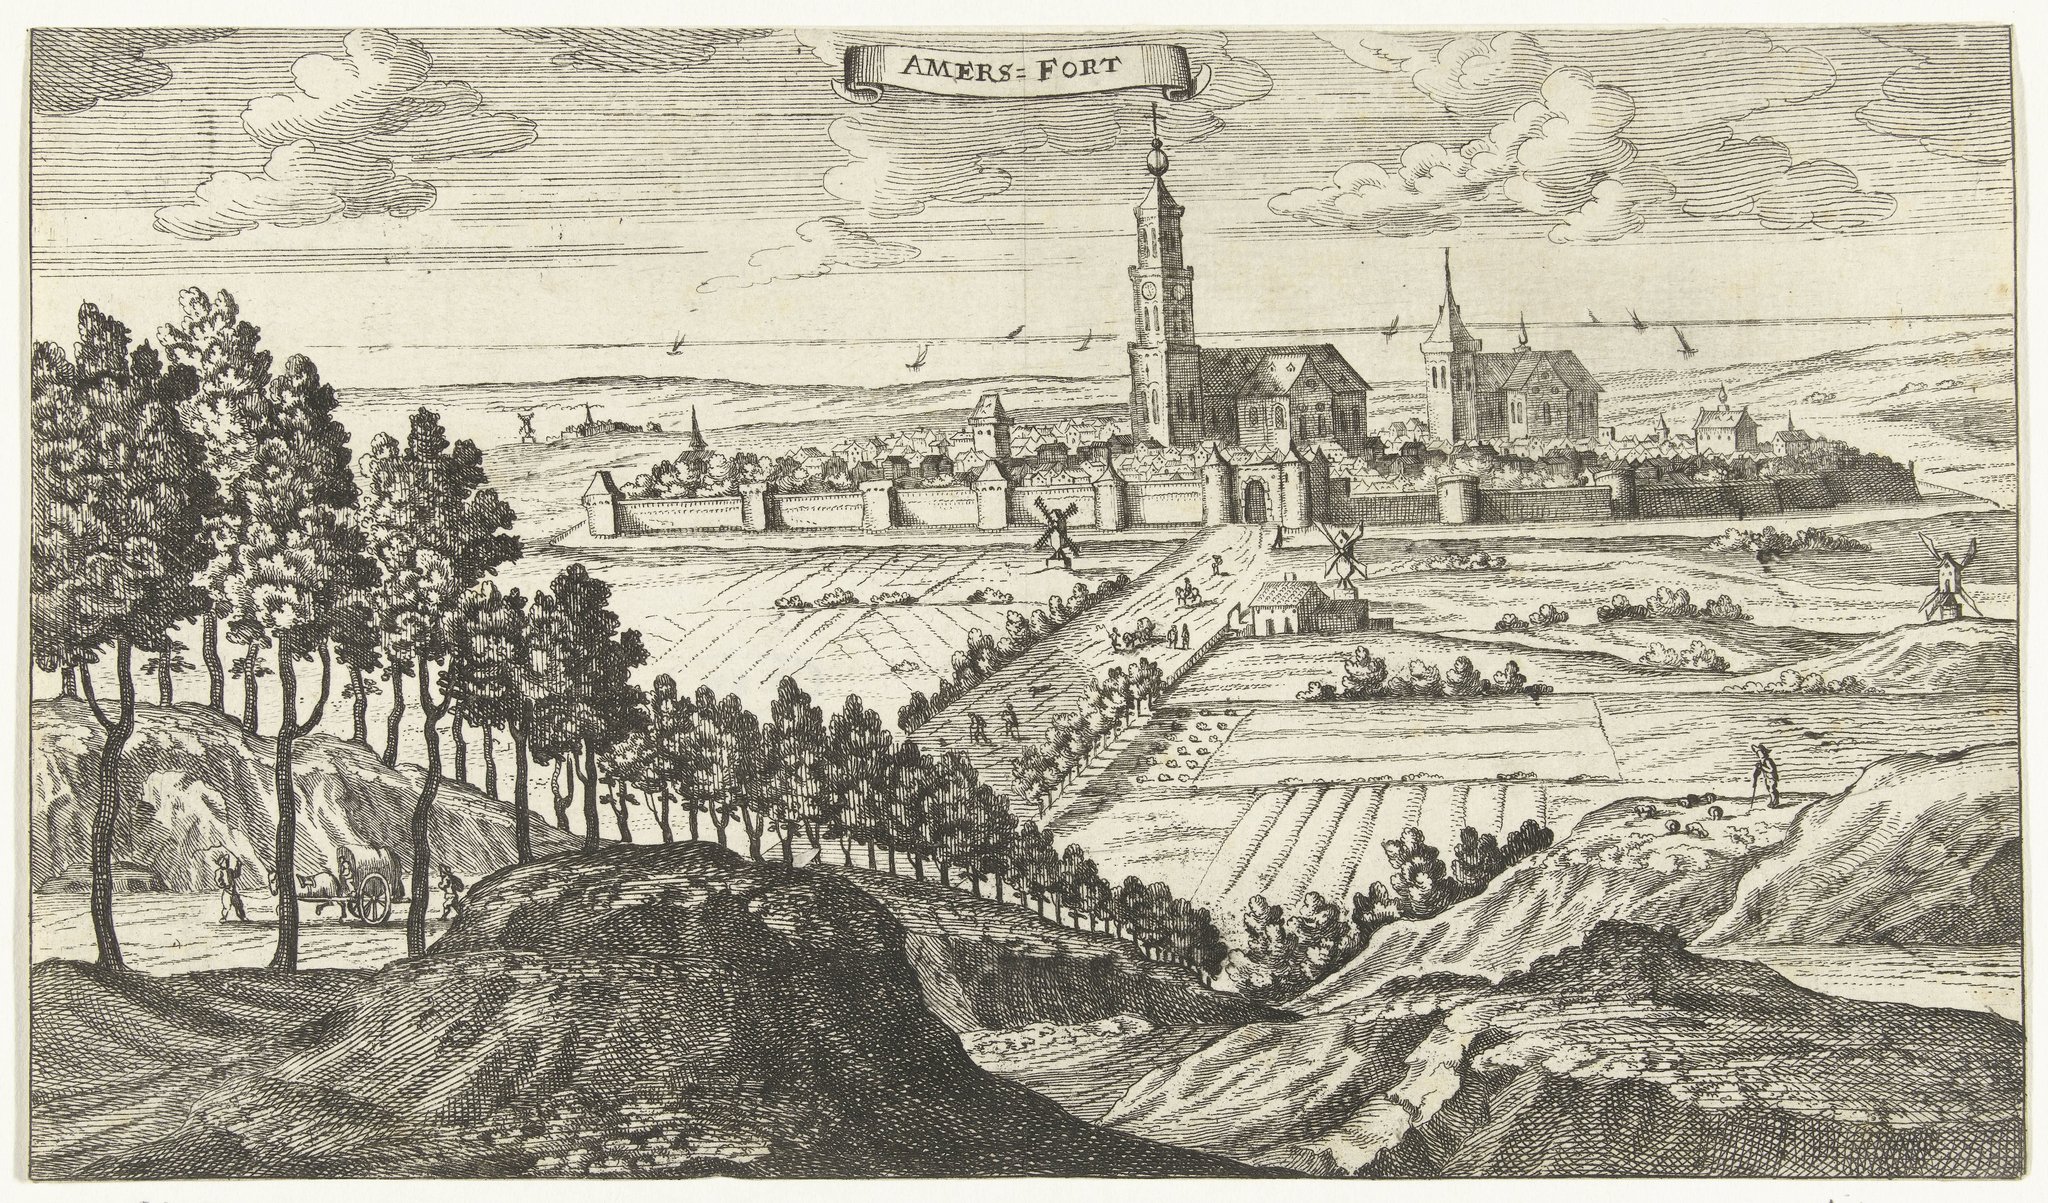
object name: print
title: Steden en vestigingen in de Republiek der Nederlanden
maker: gaspar bouttats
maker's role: print maker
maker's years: 1640-1695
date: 1679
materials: paper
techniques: etching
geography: antwerp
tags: prospect of city, town panorama, silhouette of city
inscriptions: inscription: ‘Amersfoort’, collector's mark: Lugt 2228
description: Gezicht op de stad Amersfoort. Op de voorgrond, buiten de stadsmuren, trekken wandelaars en kooplieden op de centrale weg weg van Amersfoort. Boven het stadsgezicht een cartouche met de naam van de stad.